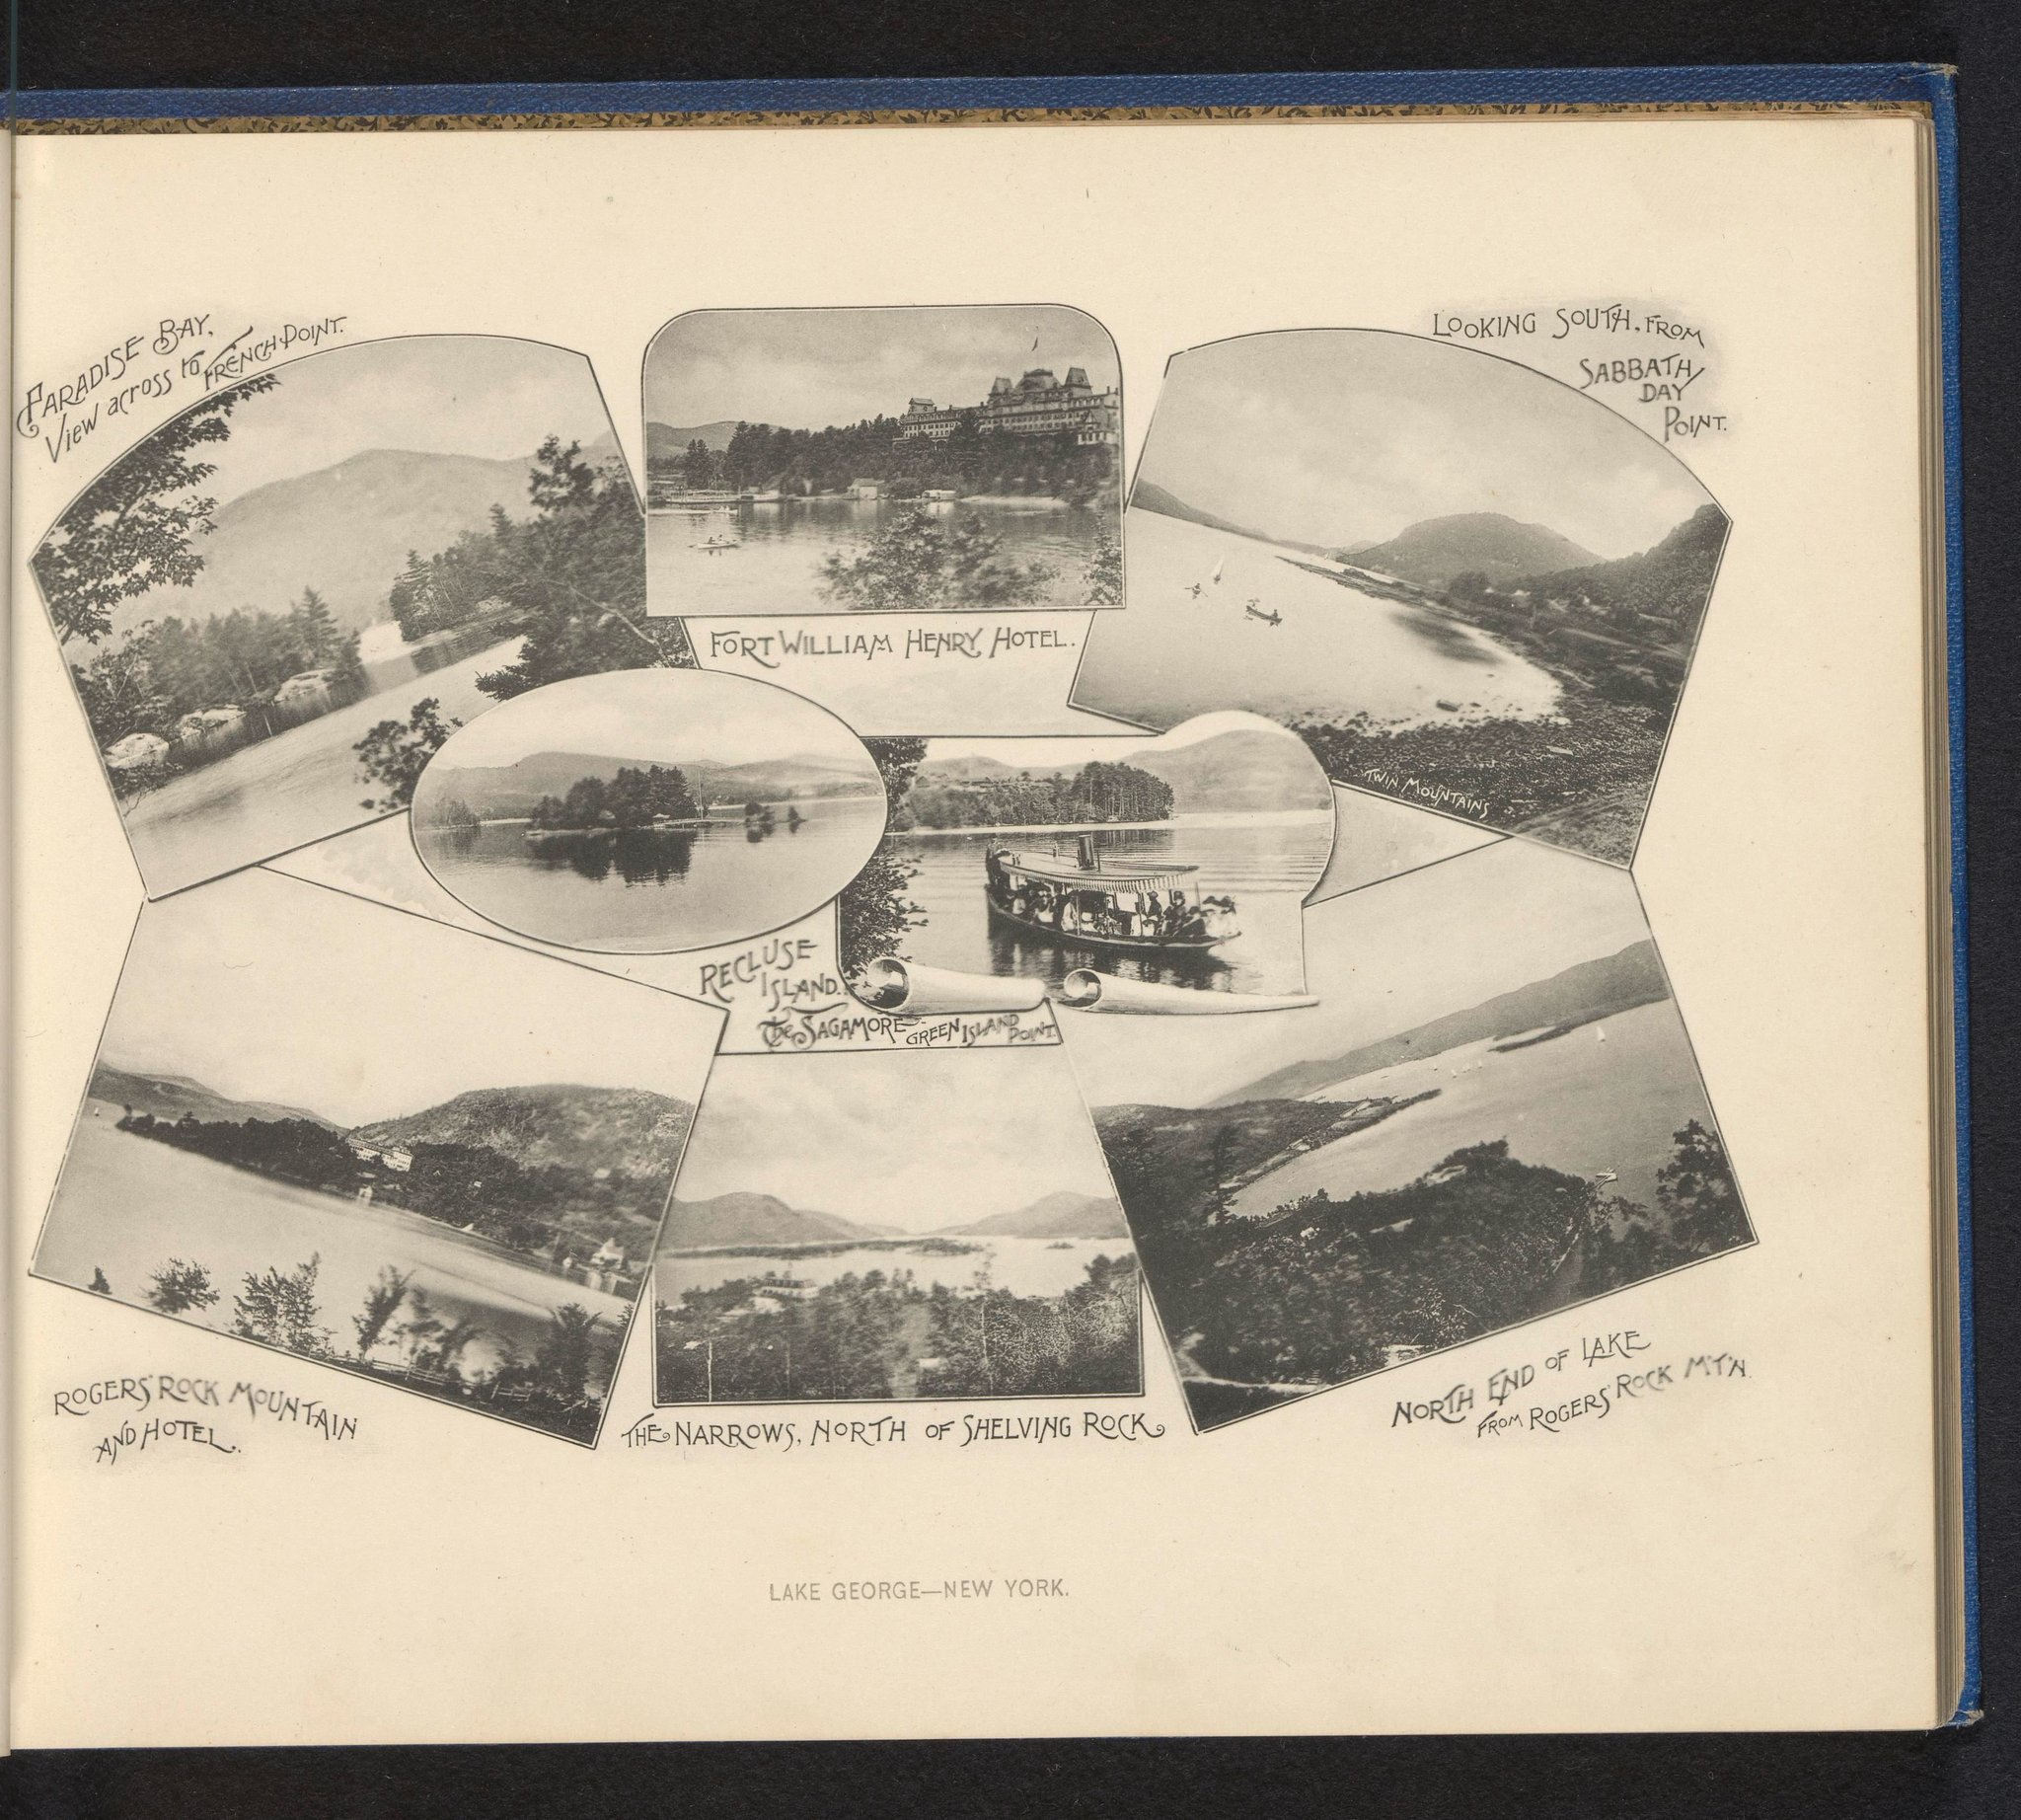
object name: page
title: Lake George - New York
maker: Anonymous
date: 1883-1893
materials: paper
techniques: photograph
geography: georgemeer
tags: lake, traffic on the water, hotel, hostelry, inn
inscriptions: inscription: ‘Paradise Bay. View across to French Point (...) North end of Lake from Rogers Rock M.T.N.’